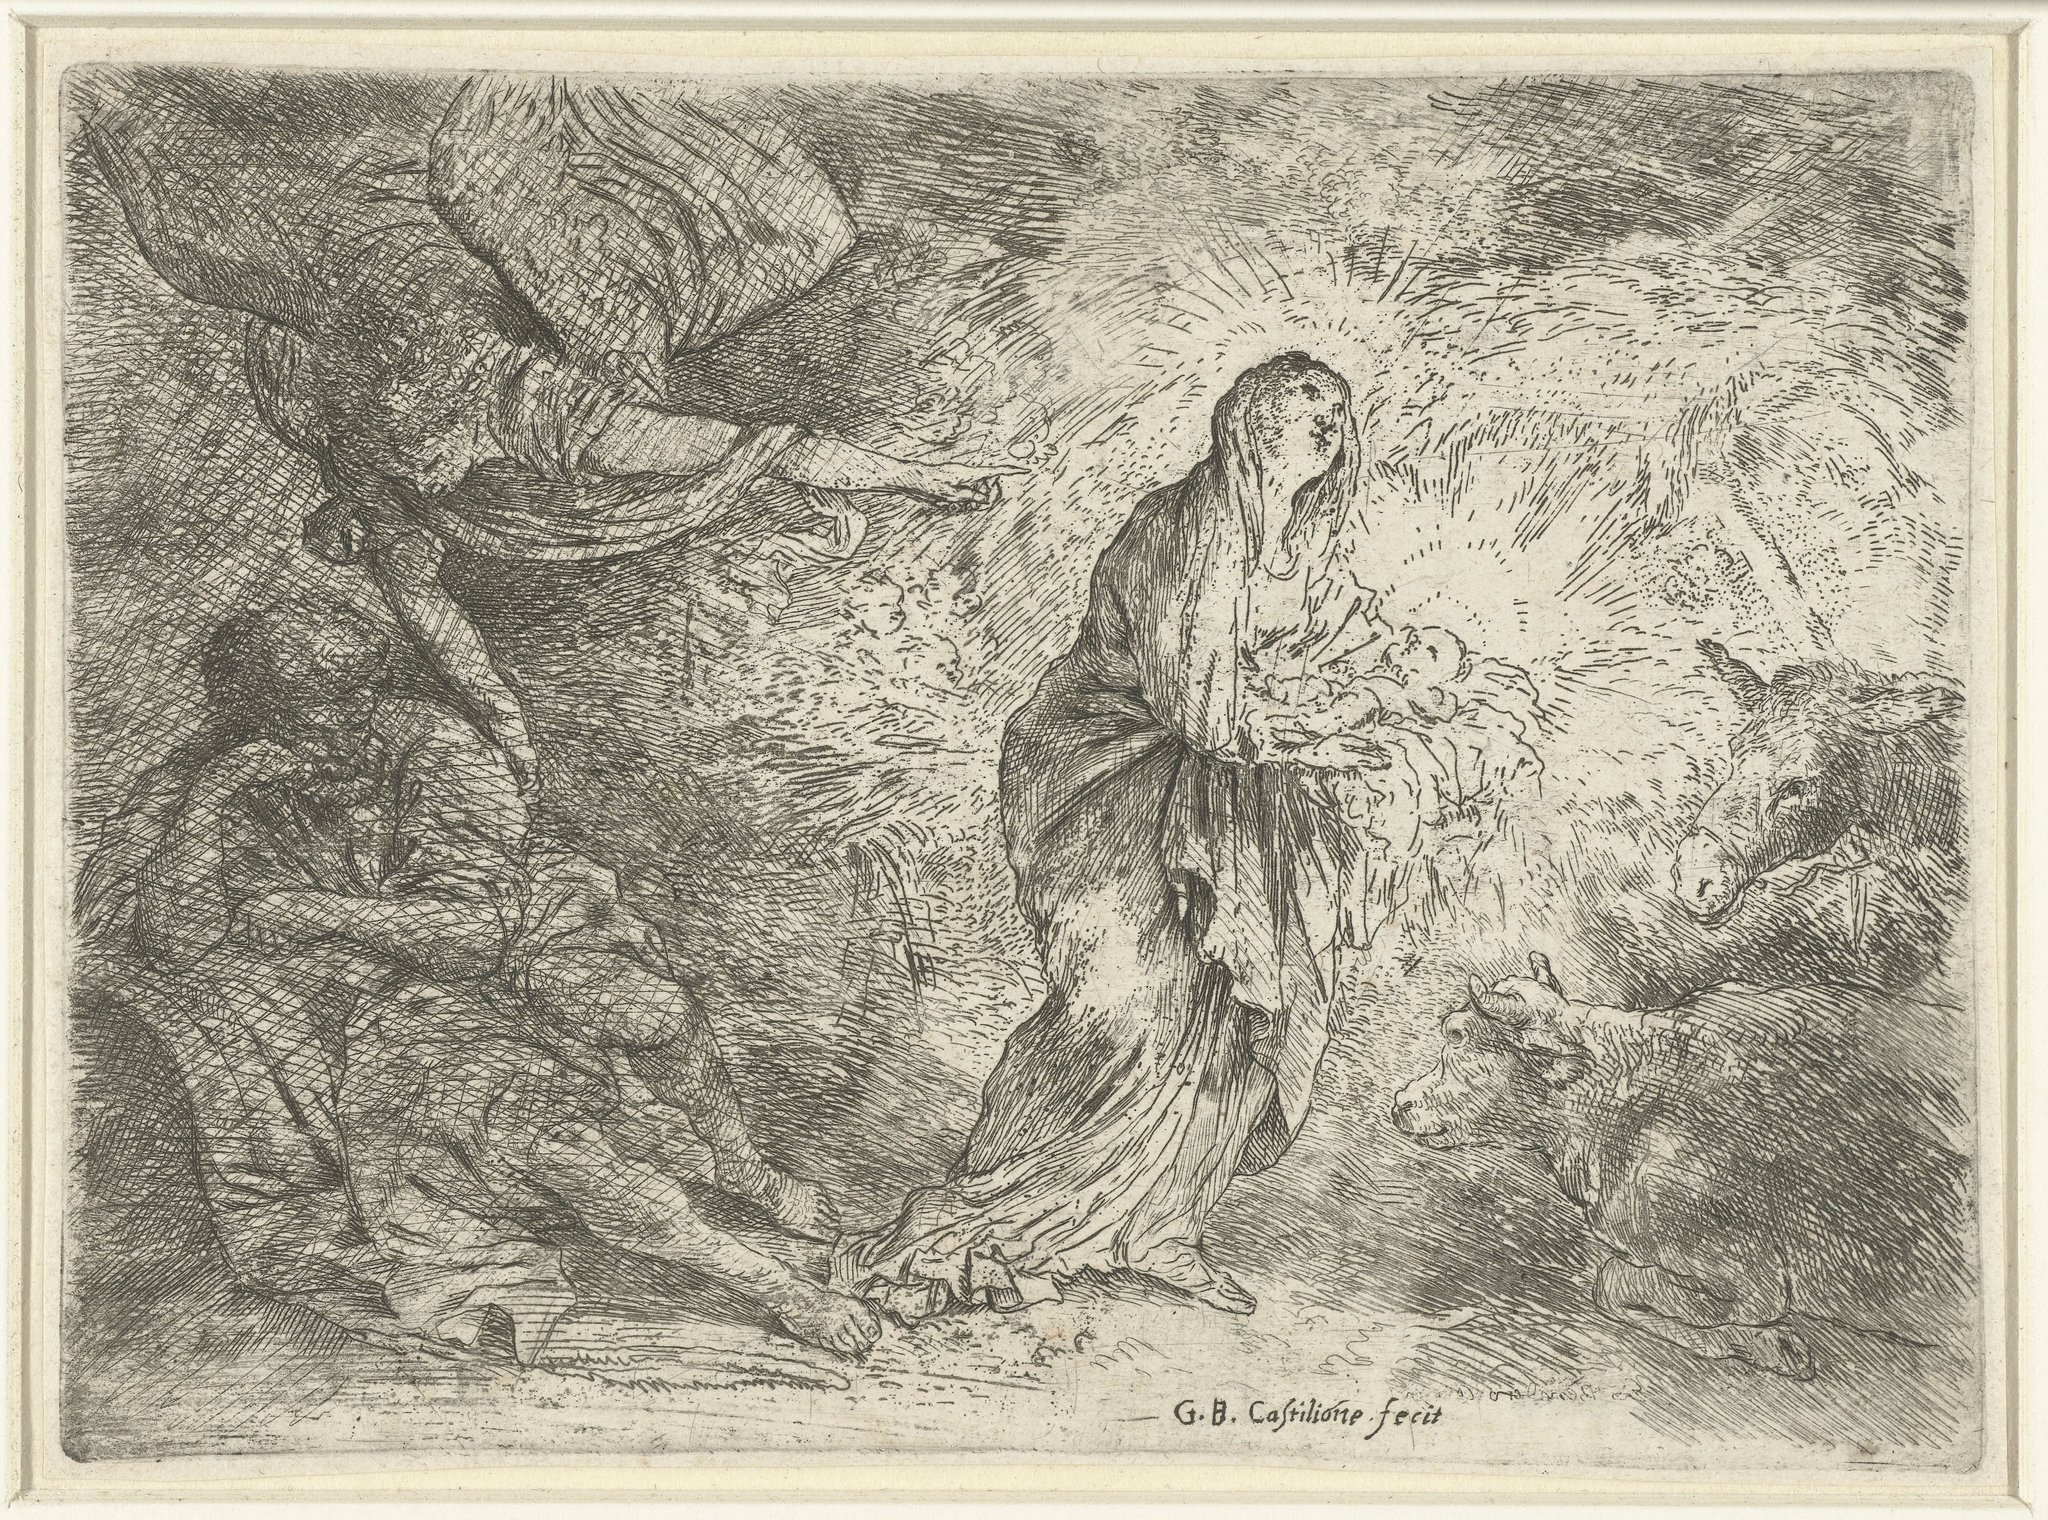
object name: print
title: De engel verschijnt aan Jozef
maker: giovanni benedetto castiglione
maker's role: draughtsman, print maker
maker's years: 1610-1665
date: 1645-1649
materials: paper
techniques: etching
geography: italy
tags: mary, joseph and the new-born christ (nativity)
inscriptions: collector's mark: Lugt 240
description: Maria met het Christuskind in haar armen in de stal, links wordt de slapend Jozef gewekt door een engel en op de geboorte van het kind gewezen.